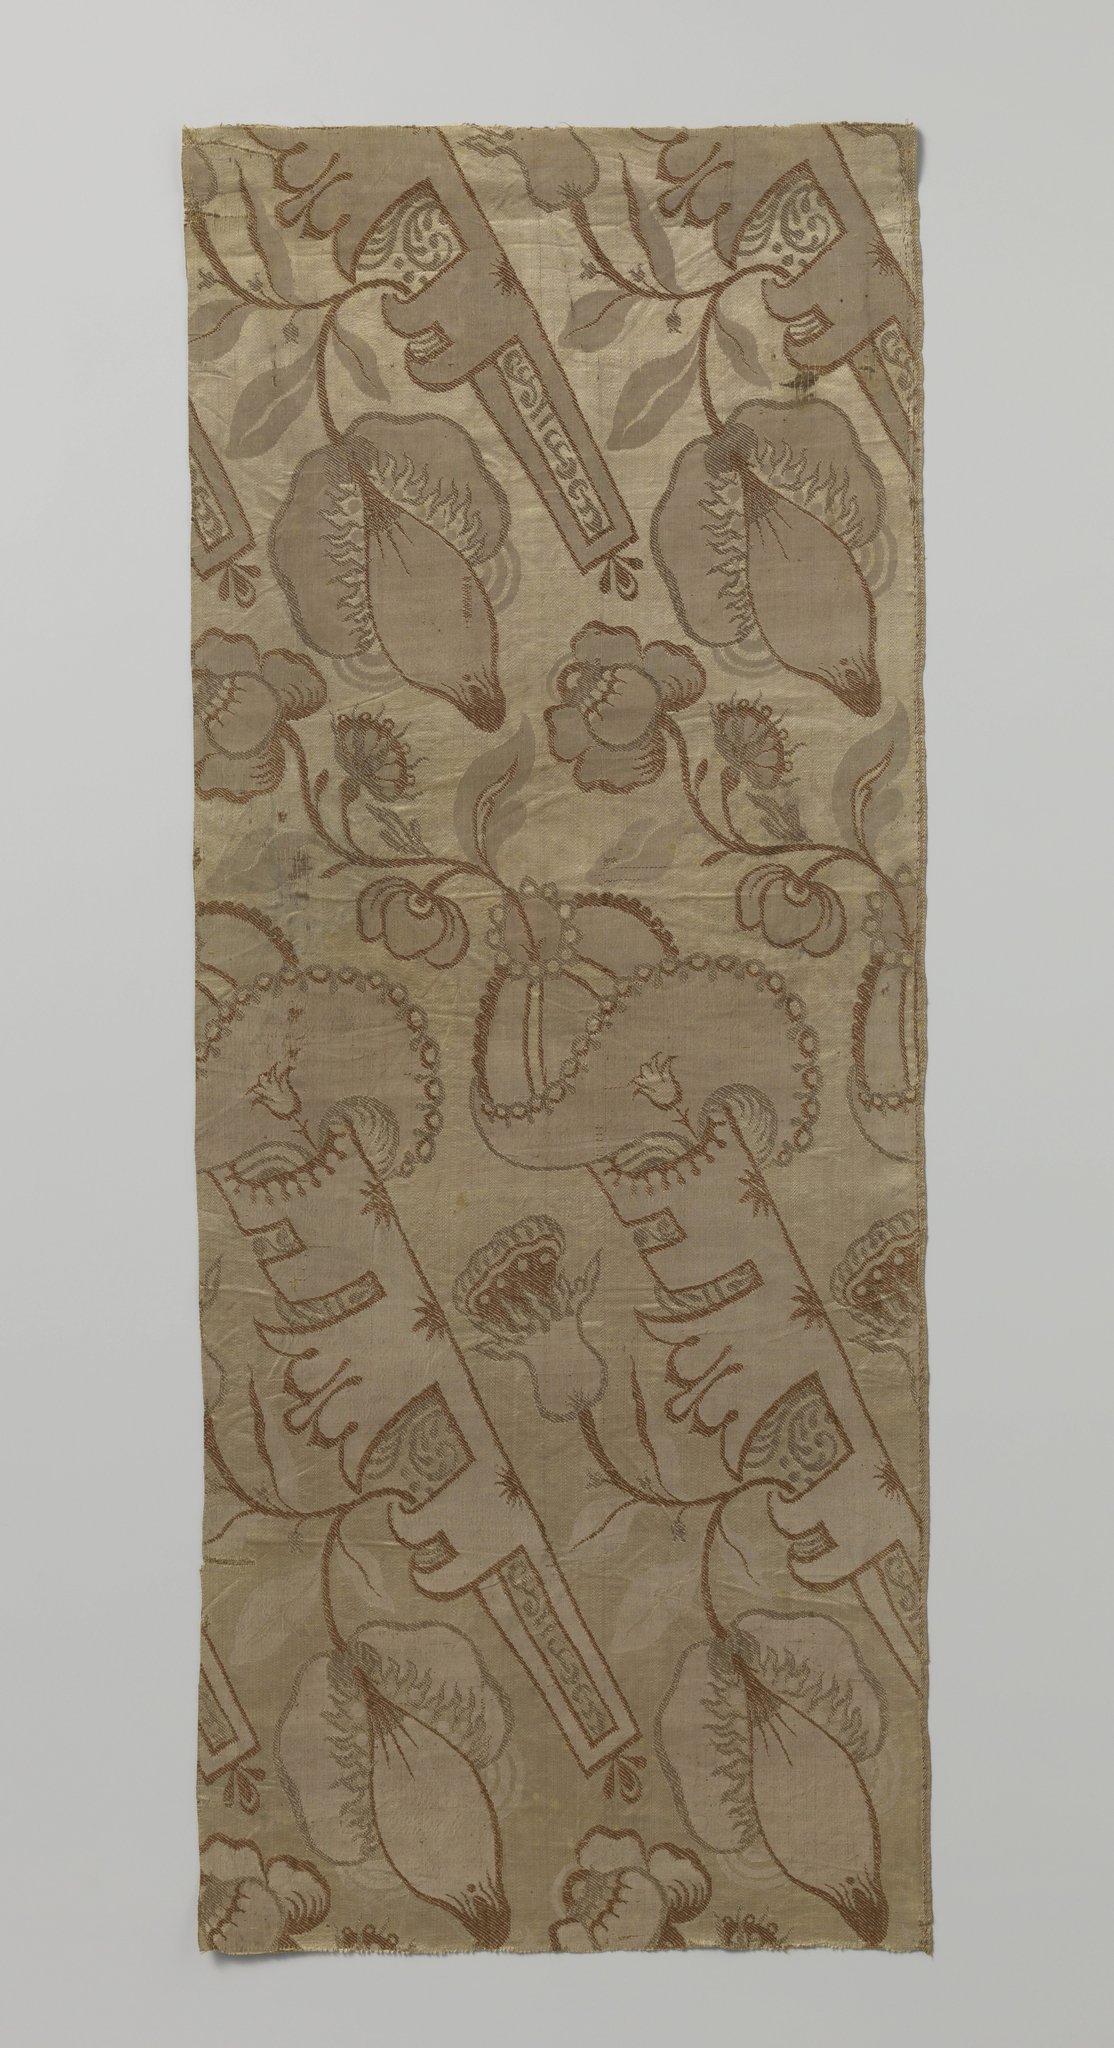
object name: zijdedamast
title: Fragment leverleurig zijdedamast met patroon van pijlenkokervormige figuren waaruit ranken, bloemen en bladeren ontwikkelen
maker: Anonymous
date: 1706-1710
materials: silk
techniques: damask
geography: england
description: Fragment zijdeweefsel in leverkleurige tinten. Het asymmetrische patroon heeft naar links gerichte pijlenkokermotieven, met een hoed gedekt, waaruit opgaande takken met bloemen en een neerhangende tak met een gerekte vrucht.